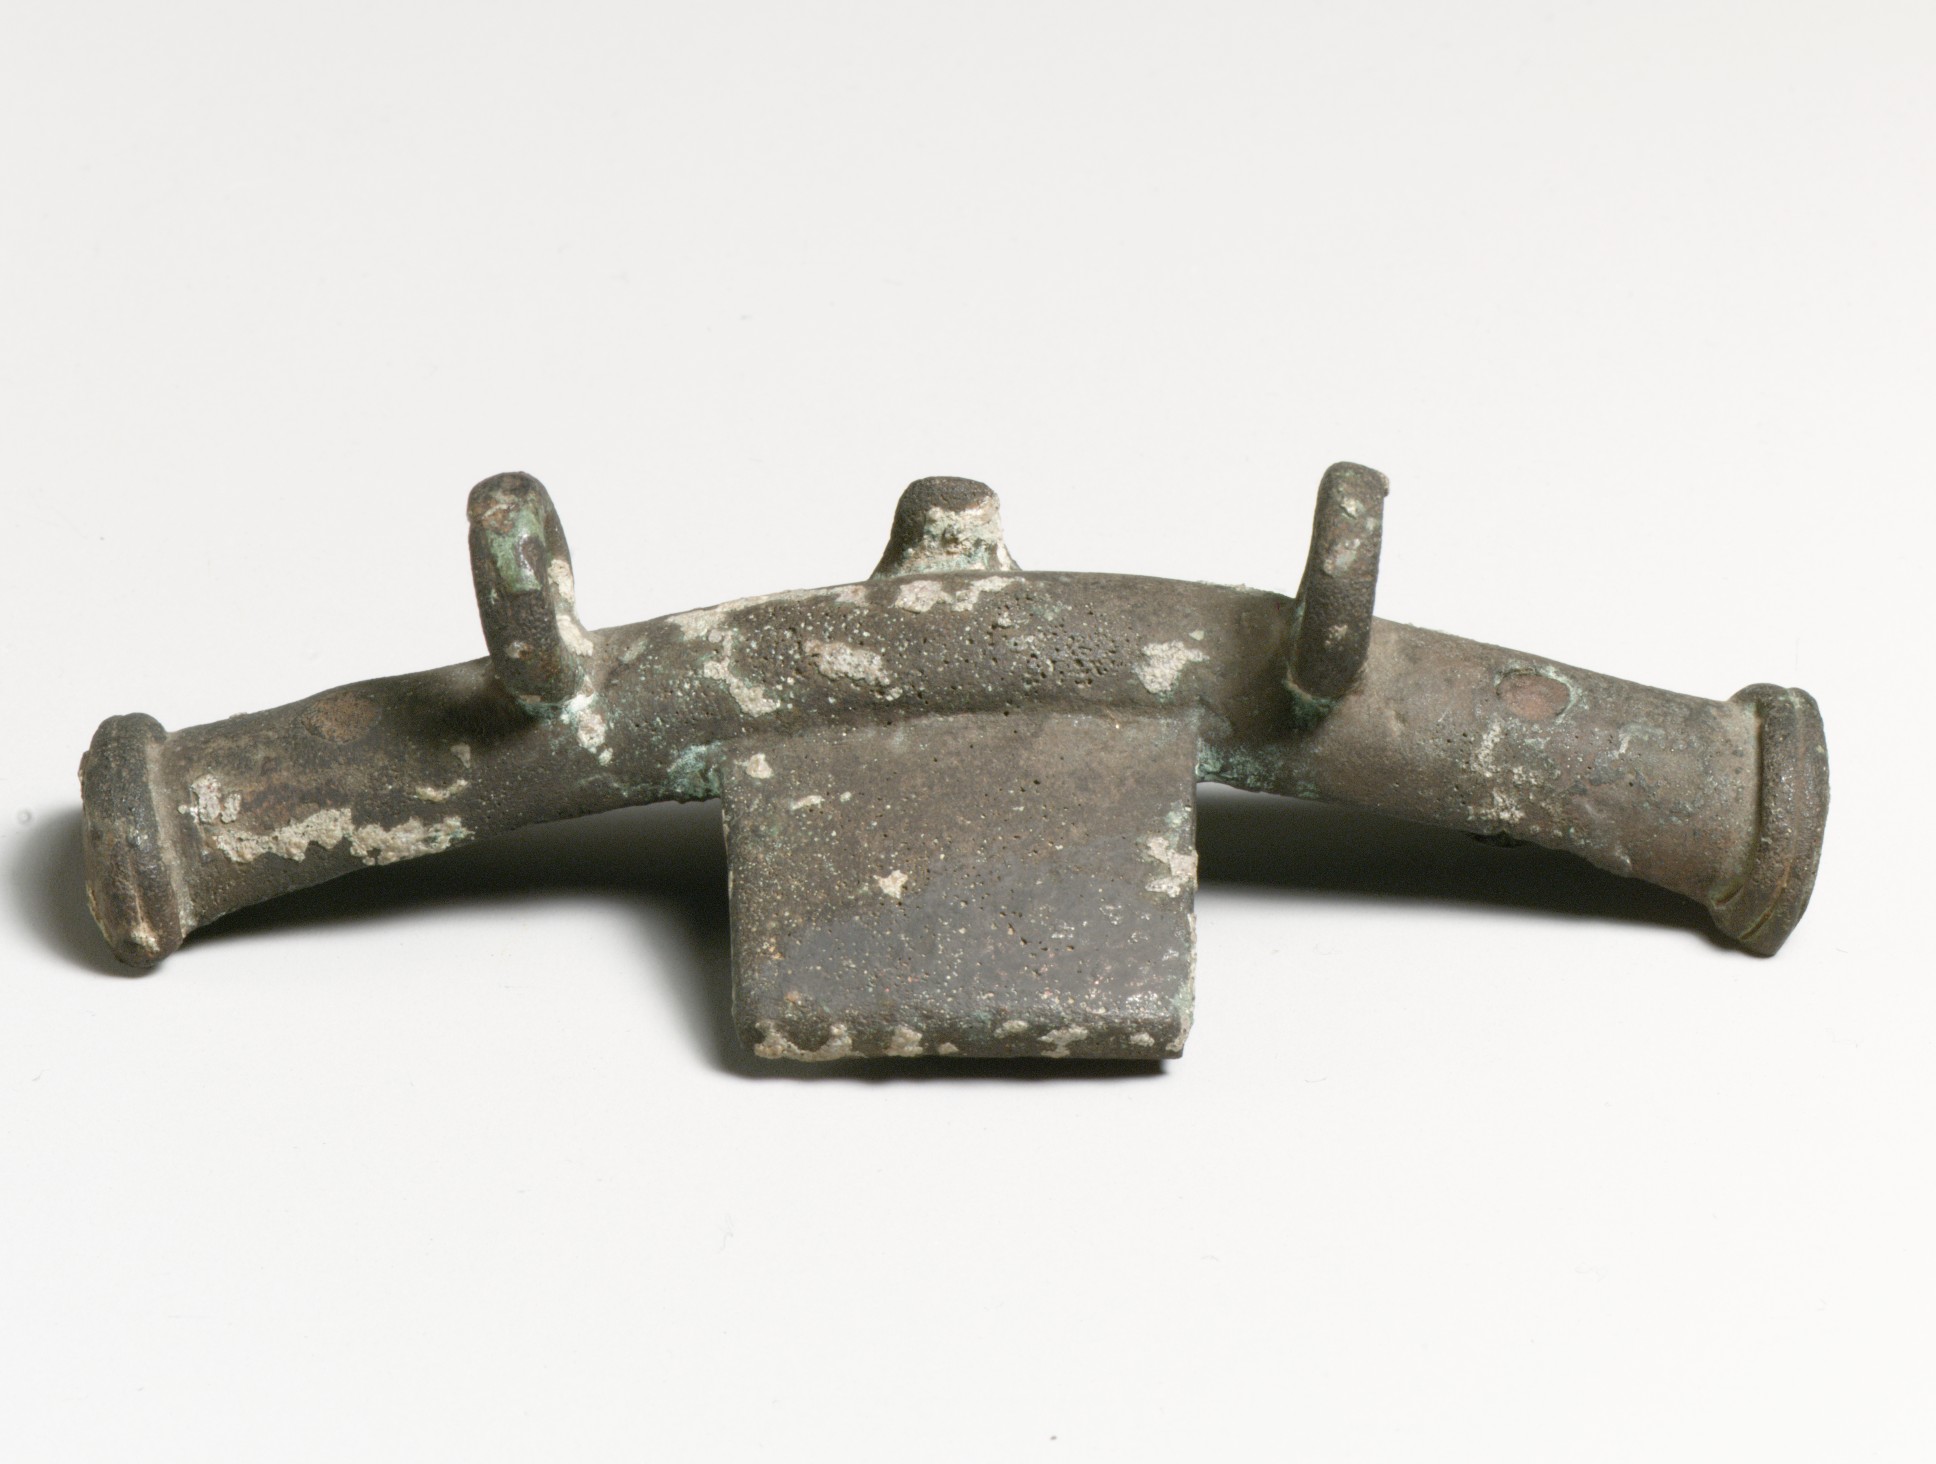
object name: handle attachment for a bowl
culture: cypriot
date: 800-601 BCE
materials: bronze